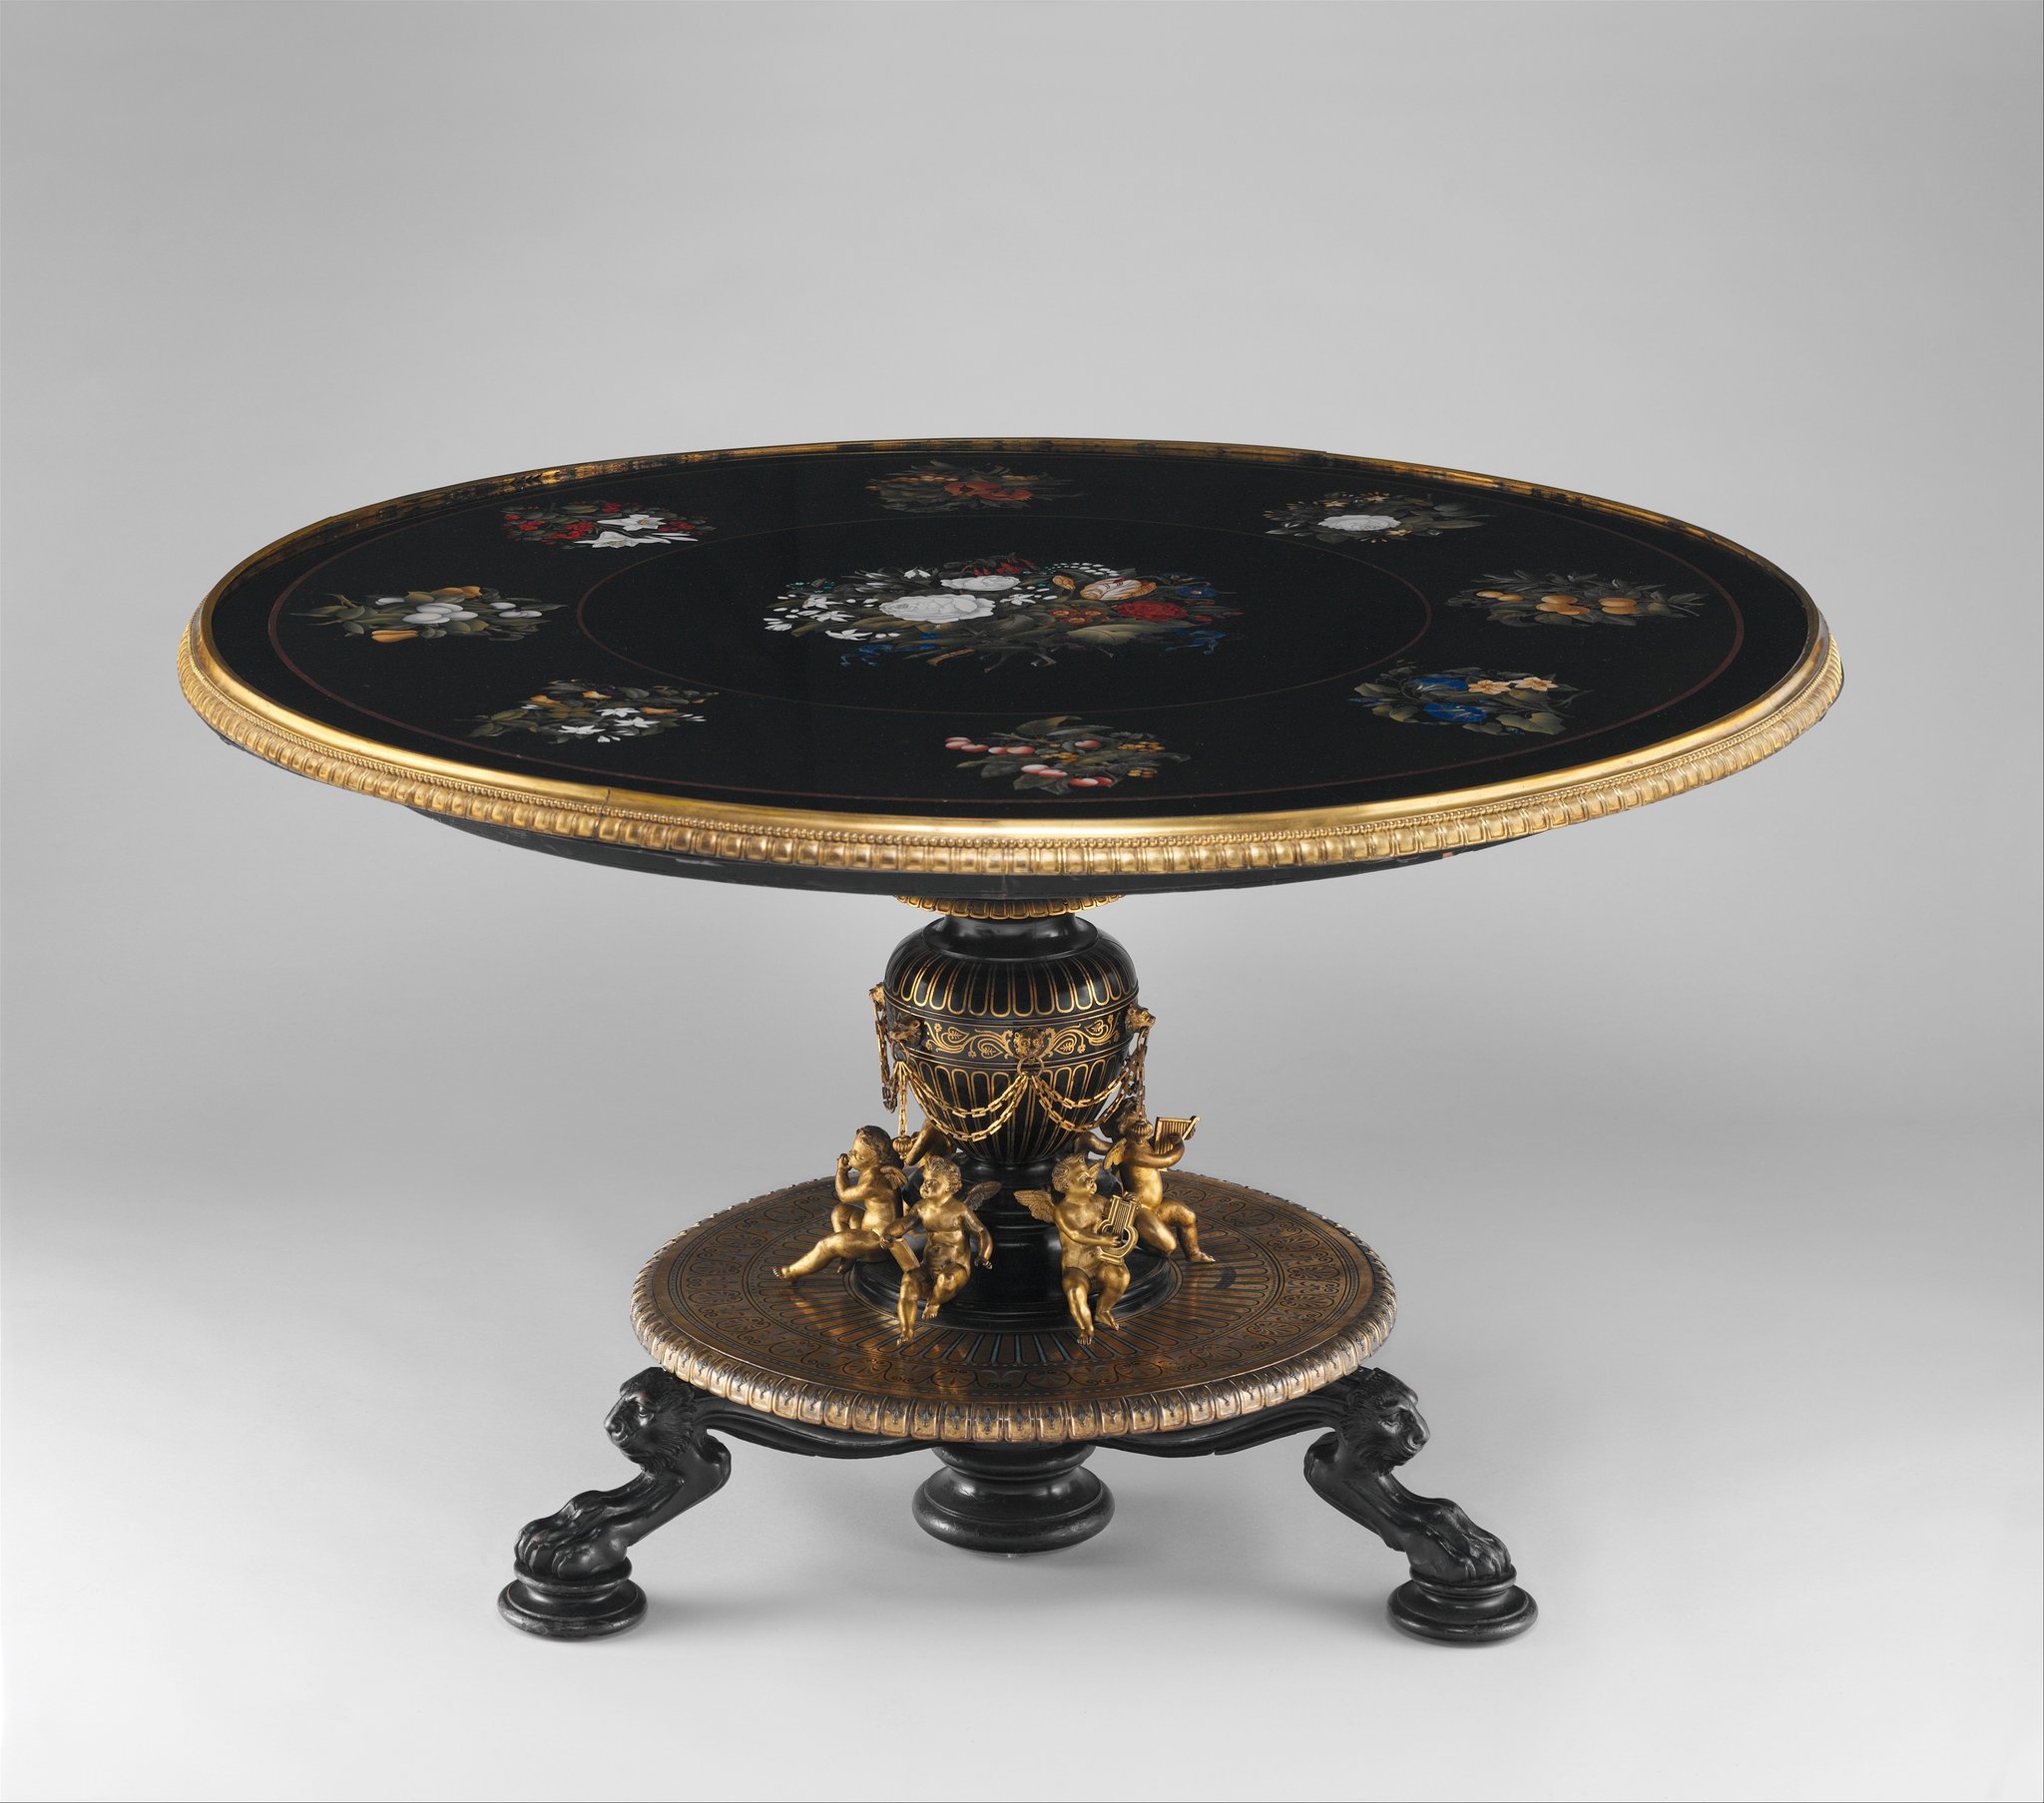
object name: table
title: Marble-top table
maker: theophil hansen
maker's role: designer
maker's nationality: danish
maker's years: 1813-1891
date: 1855-1865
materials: brass, wood, gilt bronze, marble, stone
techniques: painting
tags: musical instruments,flowers